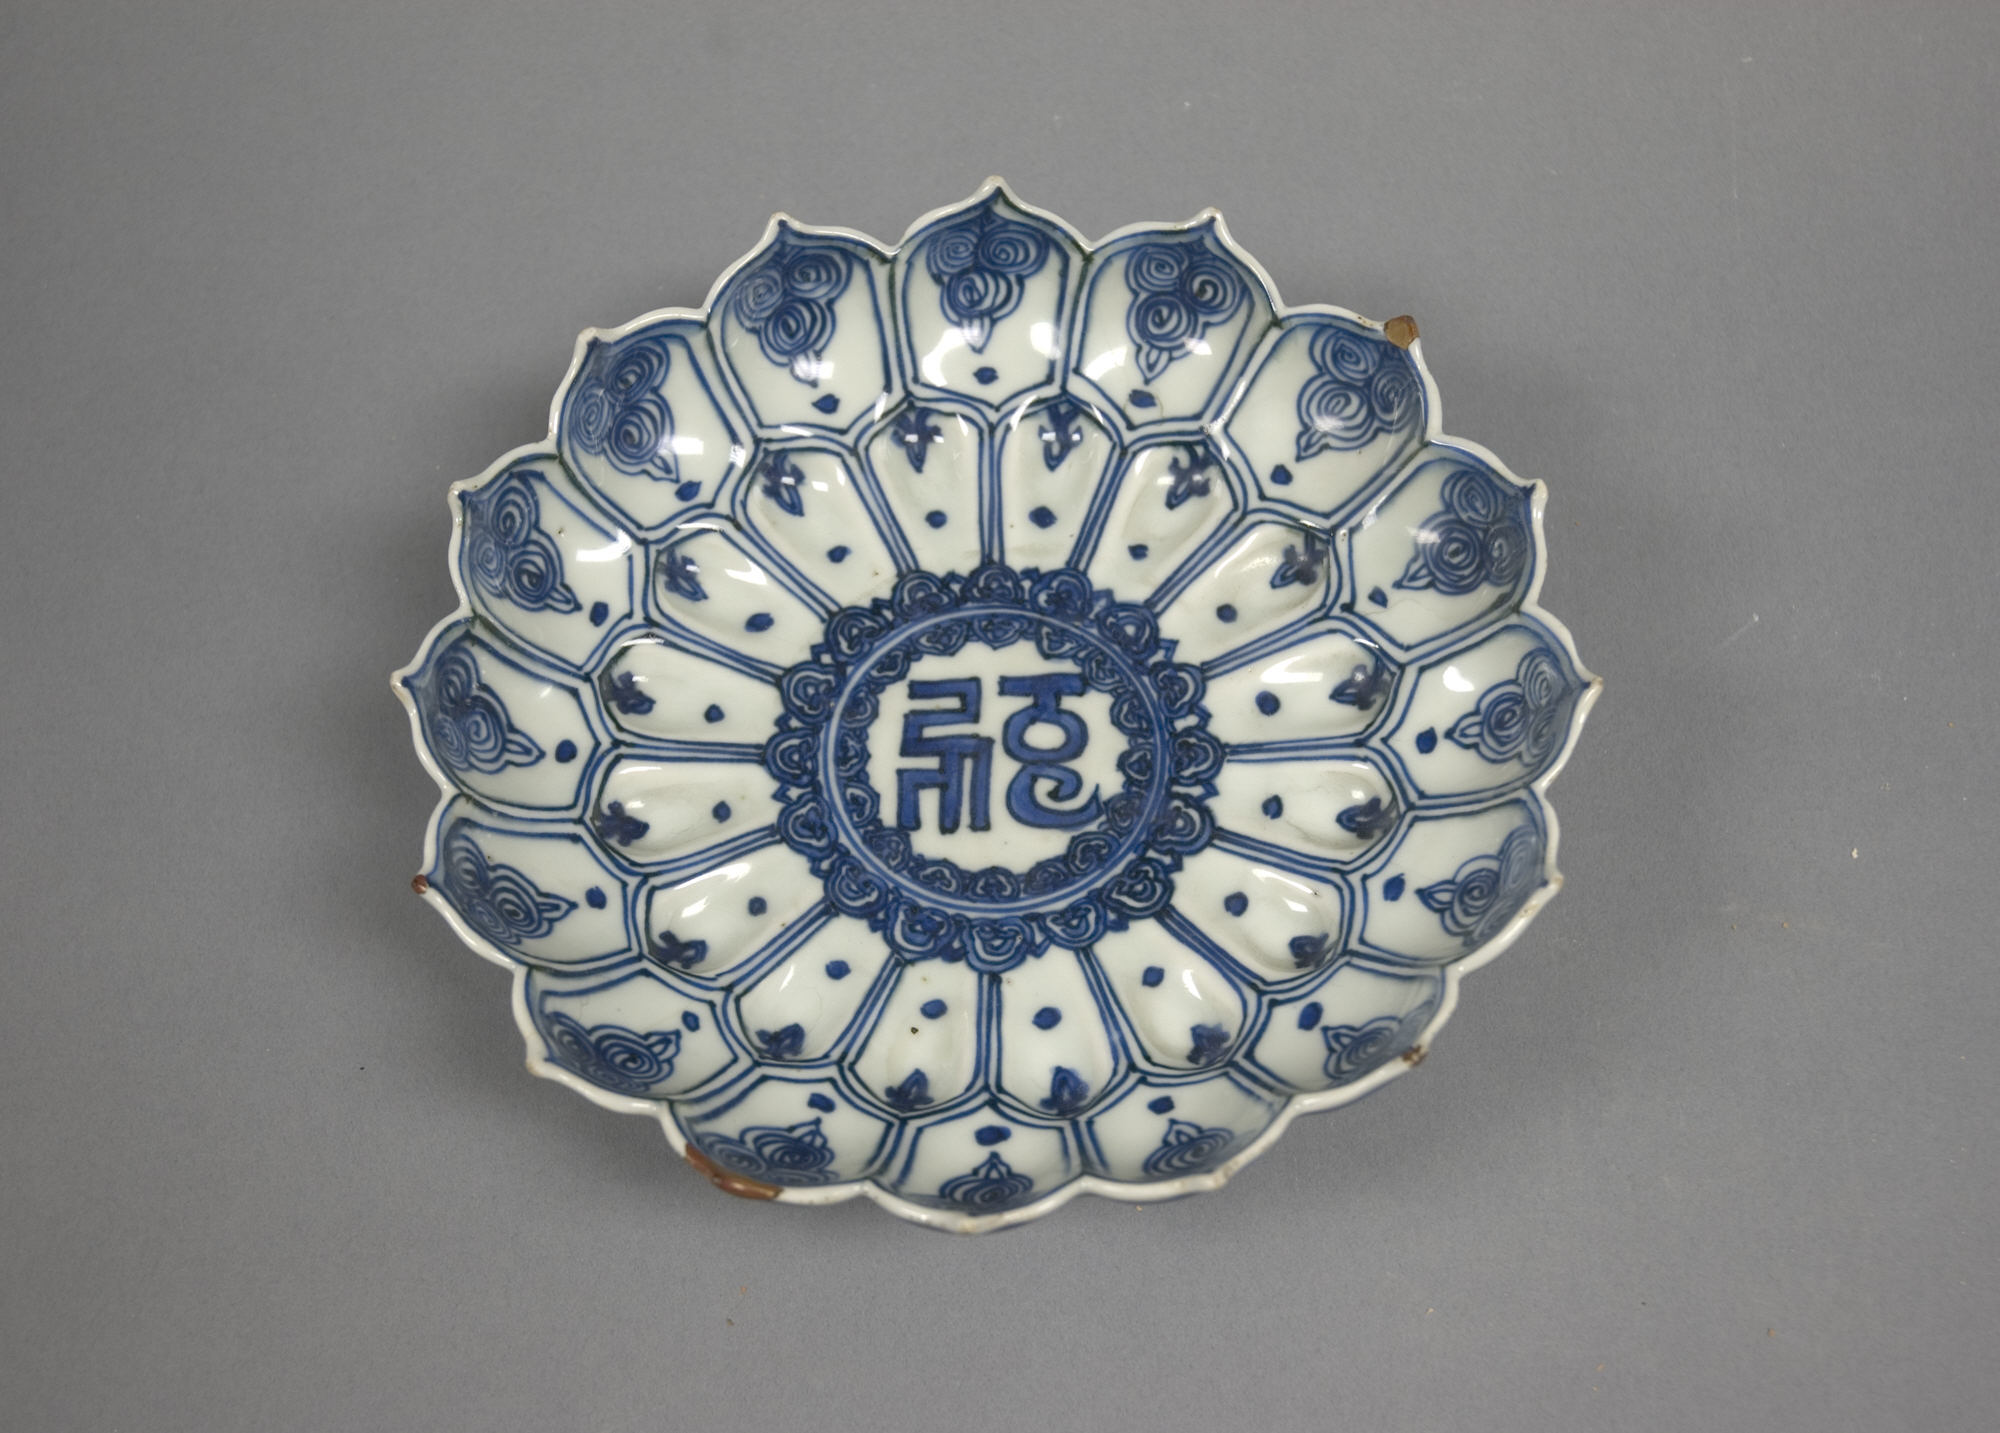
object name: bowl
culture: chinese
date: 1573-1620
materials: porcelain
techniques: painting, underglaze